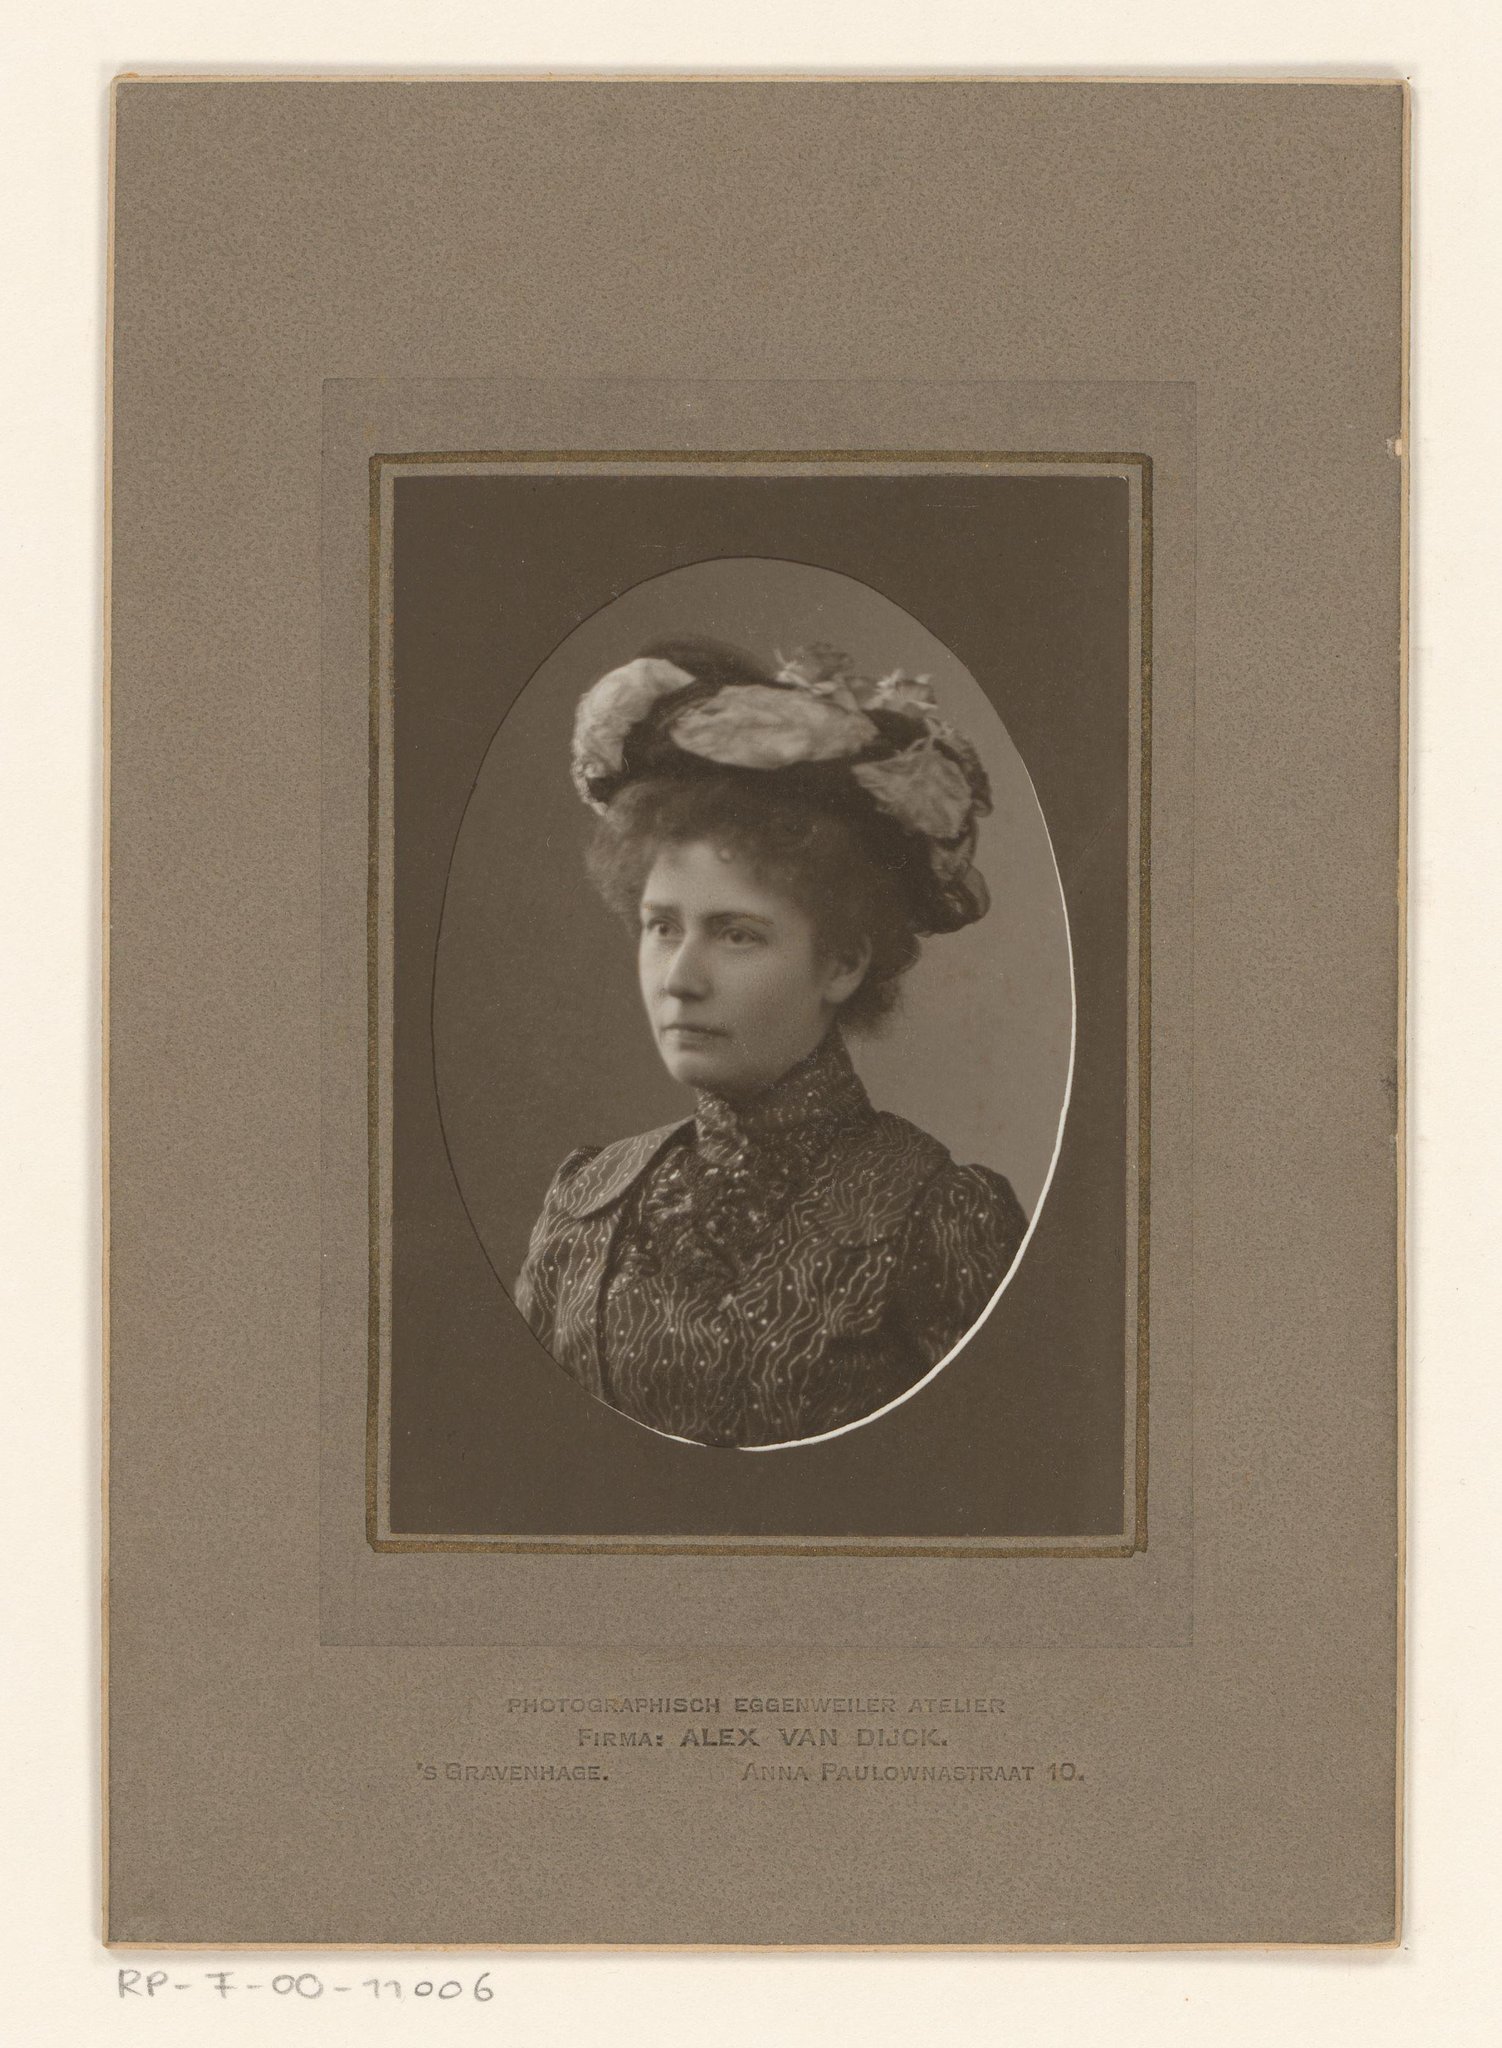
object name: photograph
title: Portret van een onbekende vrouw met hoed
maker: b. knibbe rüloffs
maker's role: fotograaf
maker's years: 1864-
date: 1885-1912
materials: cardboard, photographic support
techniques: collodion silver print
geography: the hague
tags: historical persons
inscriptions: collector's mark: Lugt 2228a, workshop stamp: ‘Photographisch-Eggenweiler-Atelier/ B. KNIBBE RÜLOFFS/ FIRMAALEX VAN DIJCK./ 'S GRAVENHAGE./ Anna Paulownastraat 10.’, inscription: ‘PHOTOGRAPHISCH EGGENWEILER ATELIER/ FIRMA: ALEX VAN DIJCK./ 'S GRAVENHAGE. ANNA PAULOWNASTRAAT 10.’, :